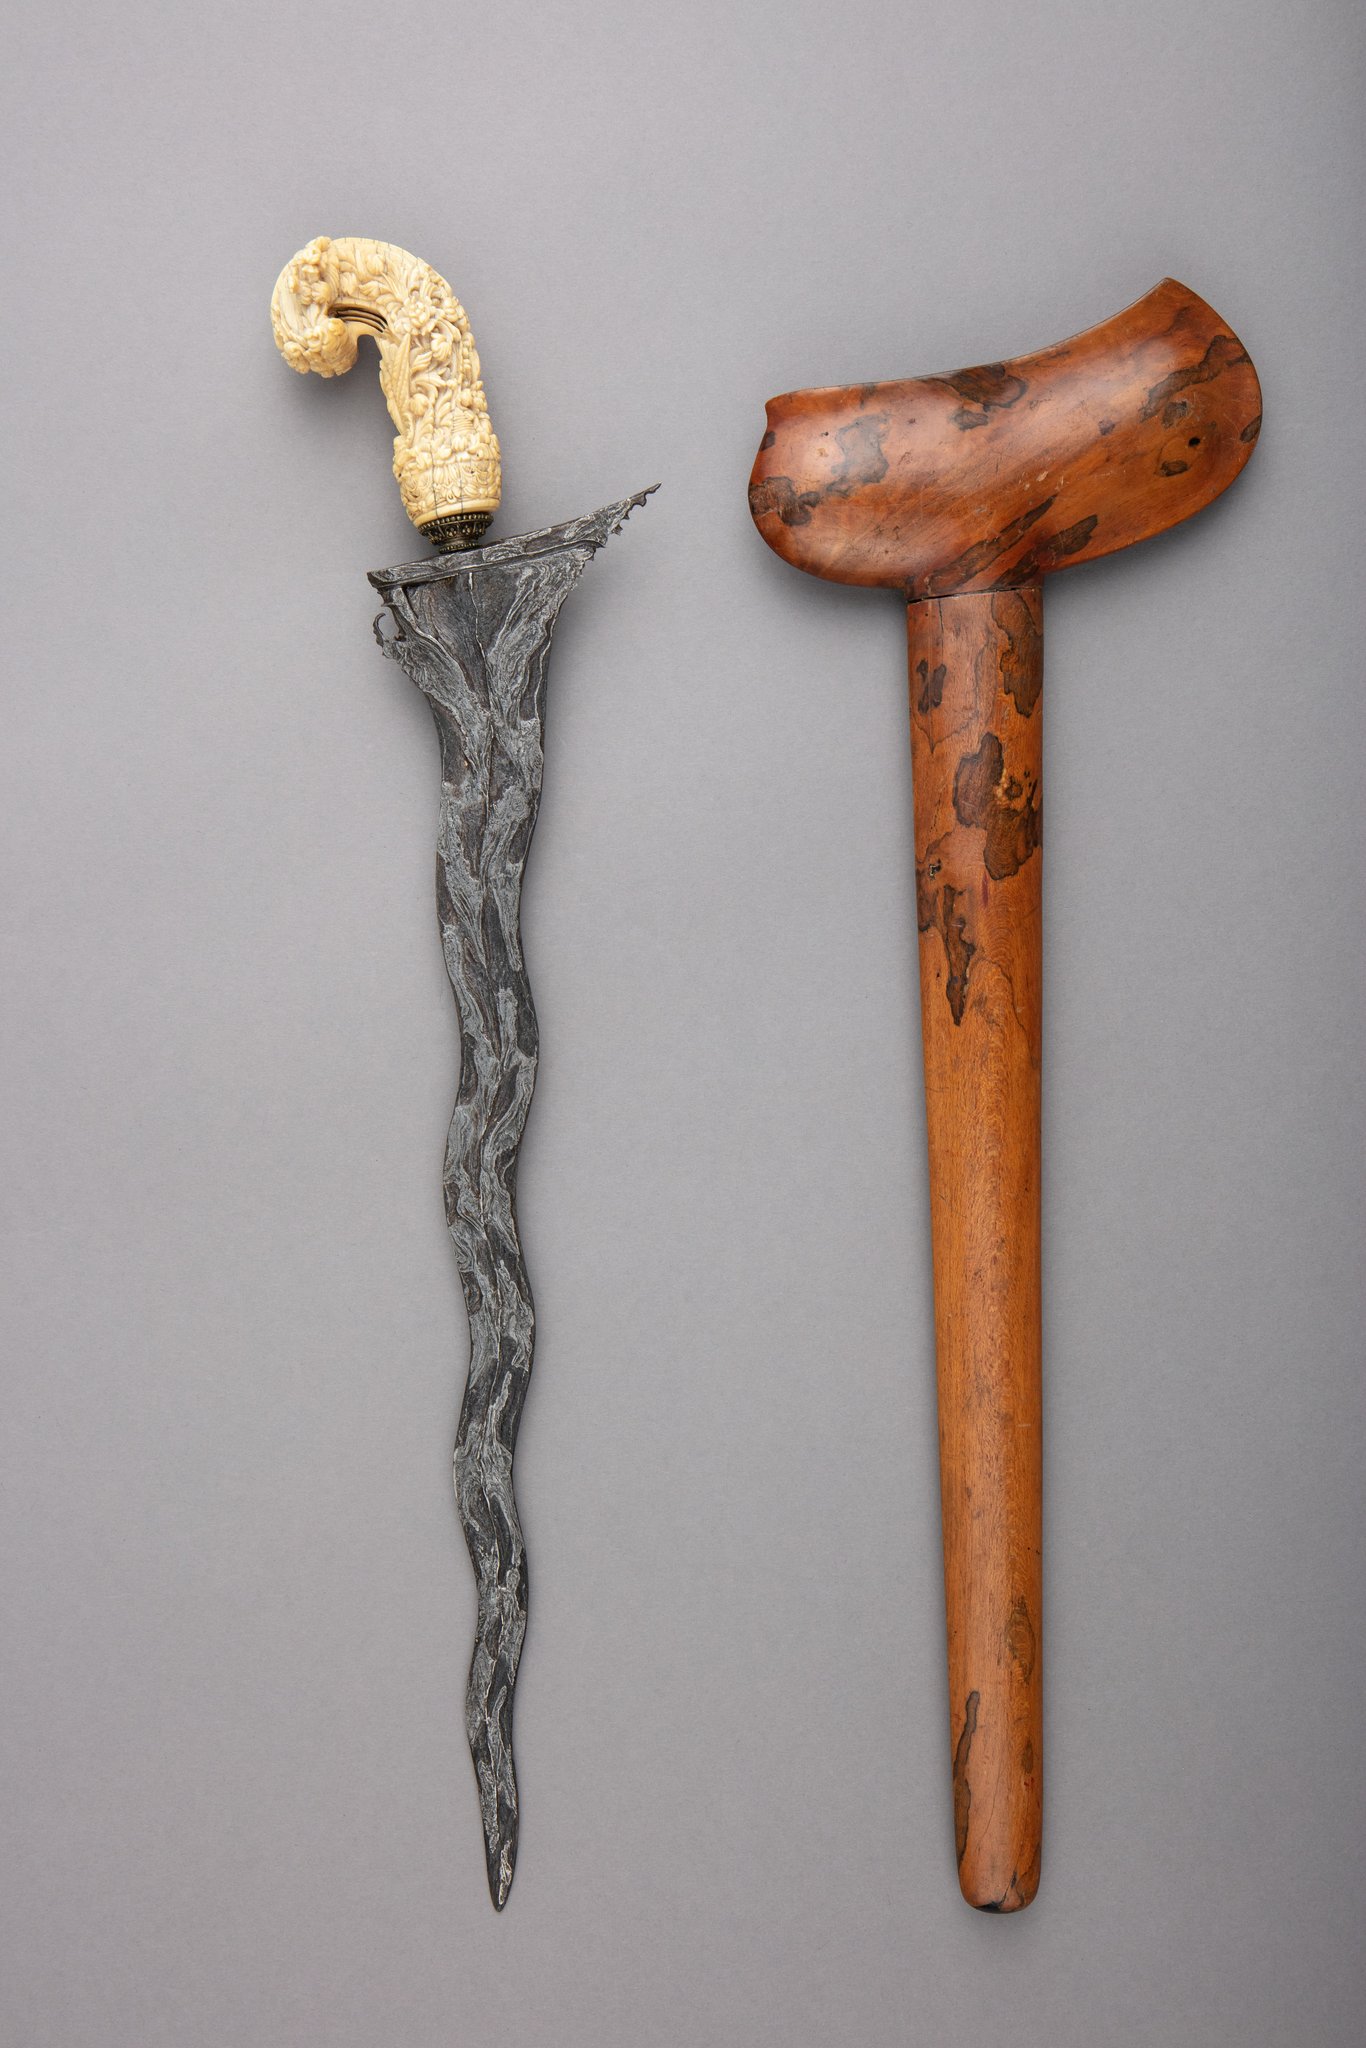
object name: kris with sheath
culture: madurese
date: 1701-1900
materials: brass, ivory, steel, wood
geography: indonesia